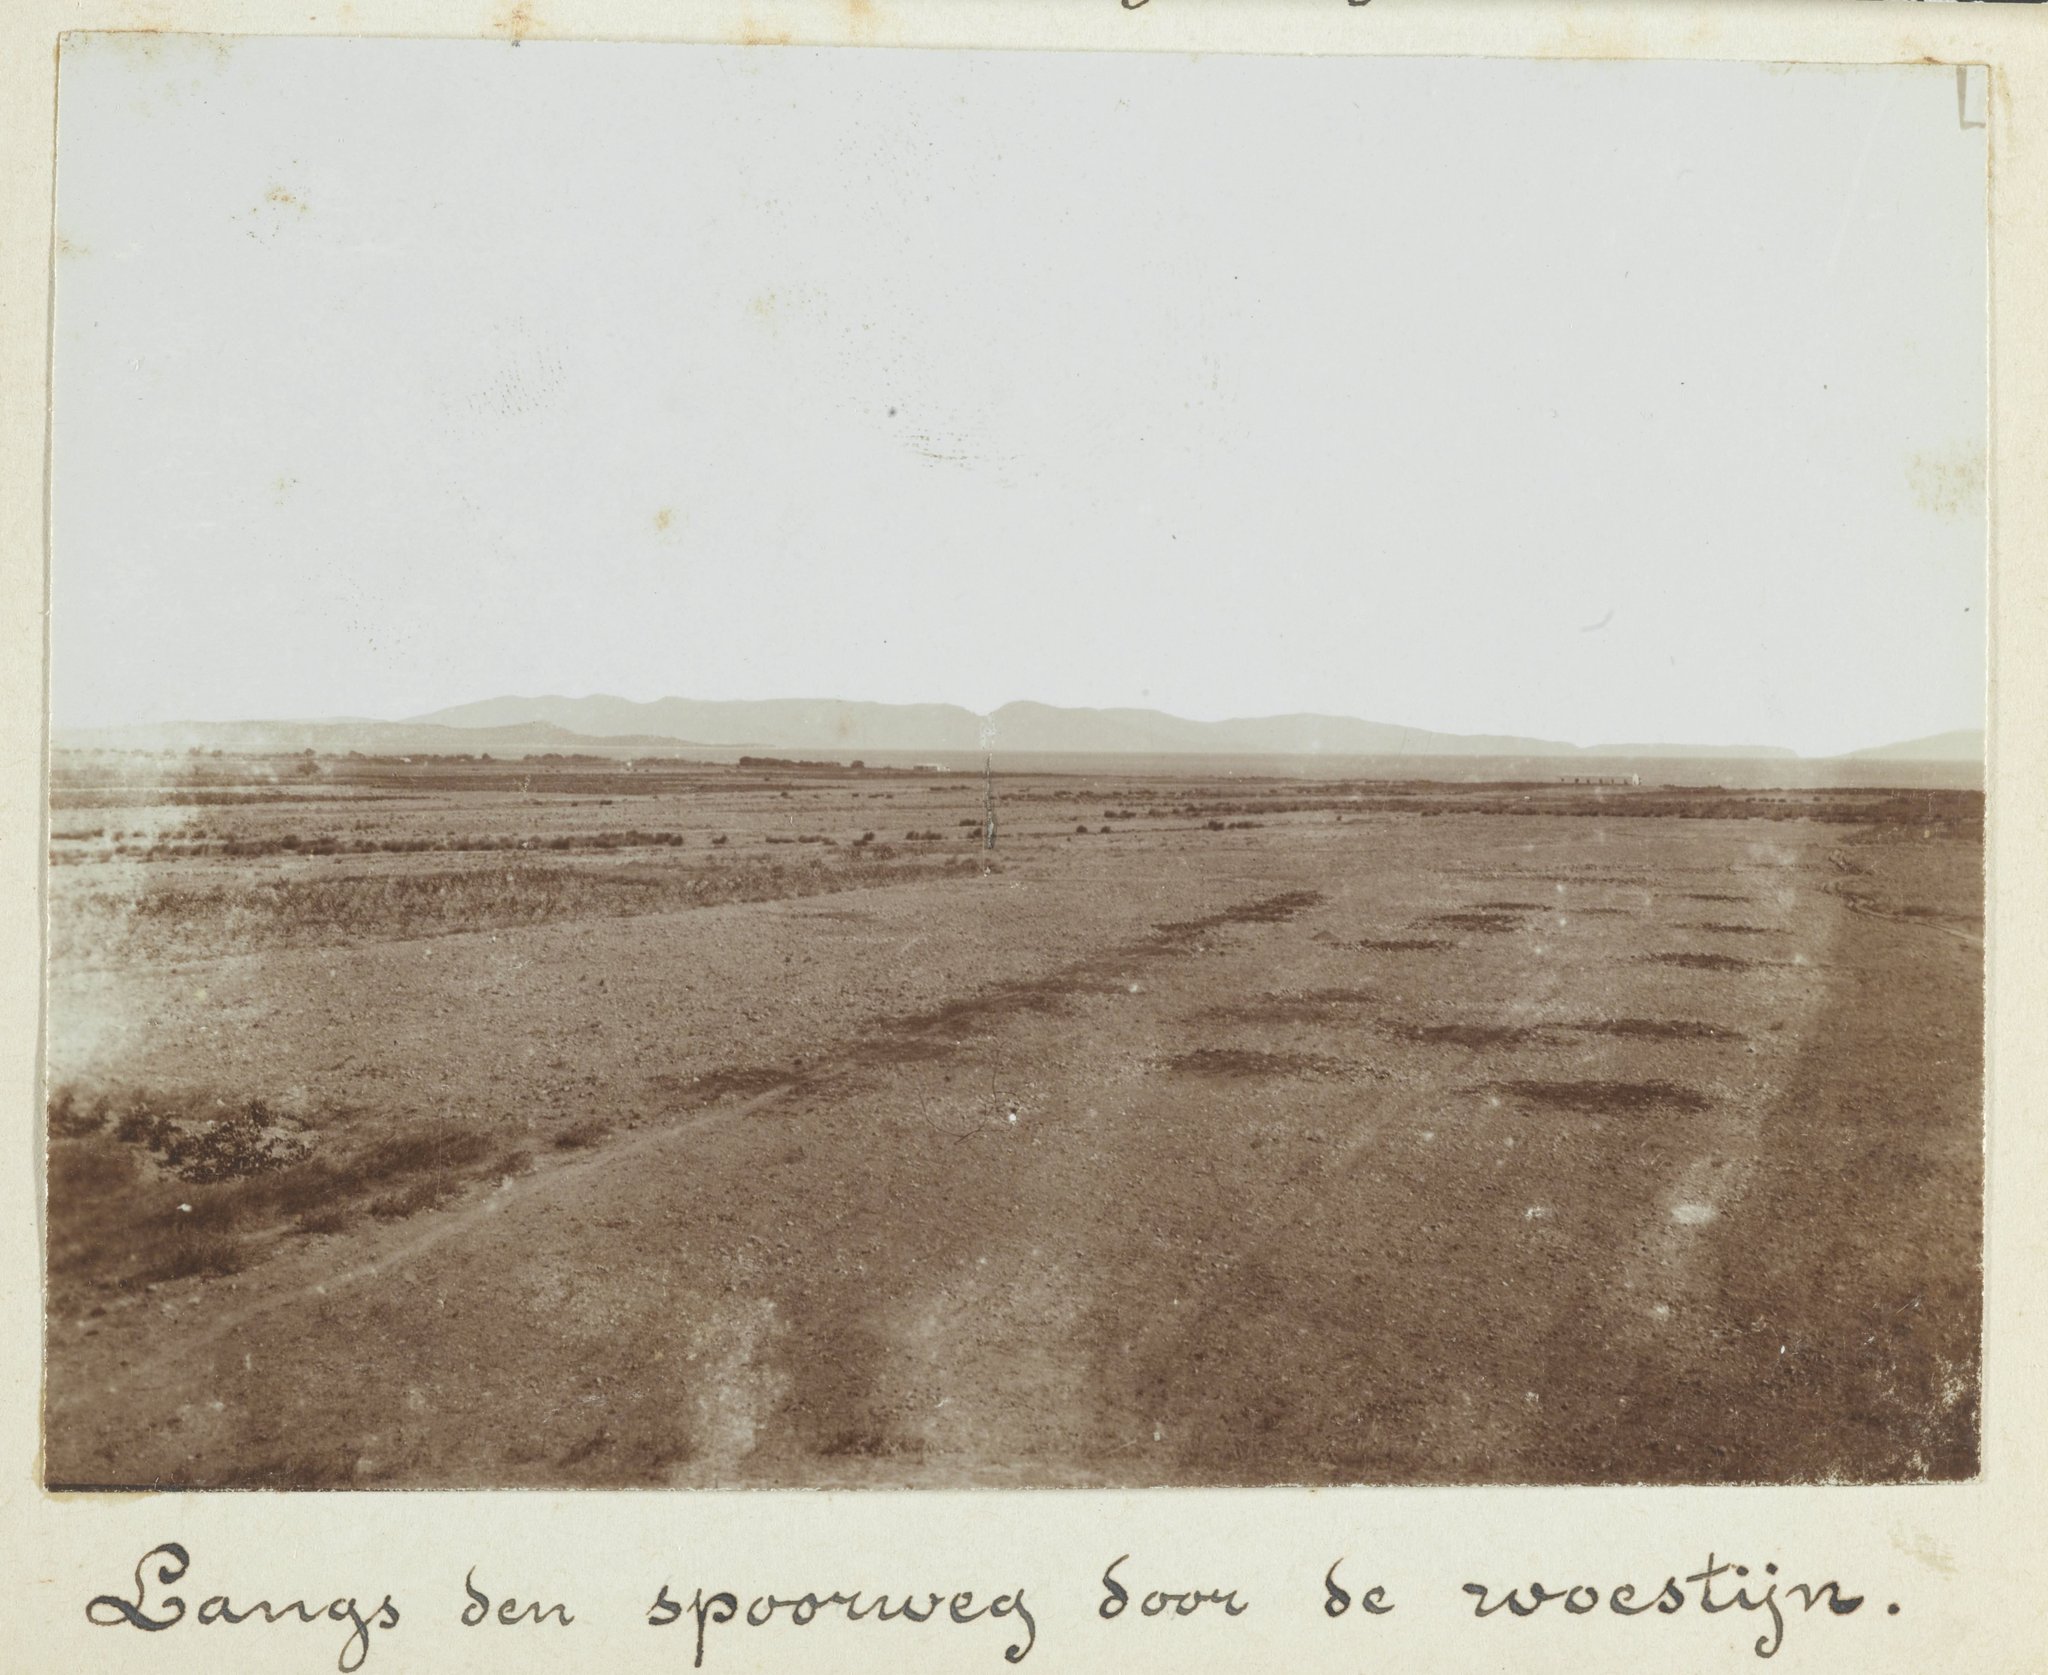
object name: page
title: Langs den spoorweg door de woestijn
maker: johannes lodewijk heldring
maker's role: fotograaf, predikant, schrijver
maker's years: 1852-1923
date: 1898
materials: paper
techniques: collodion silver print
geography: syria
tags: desert